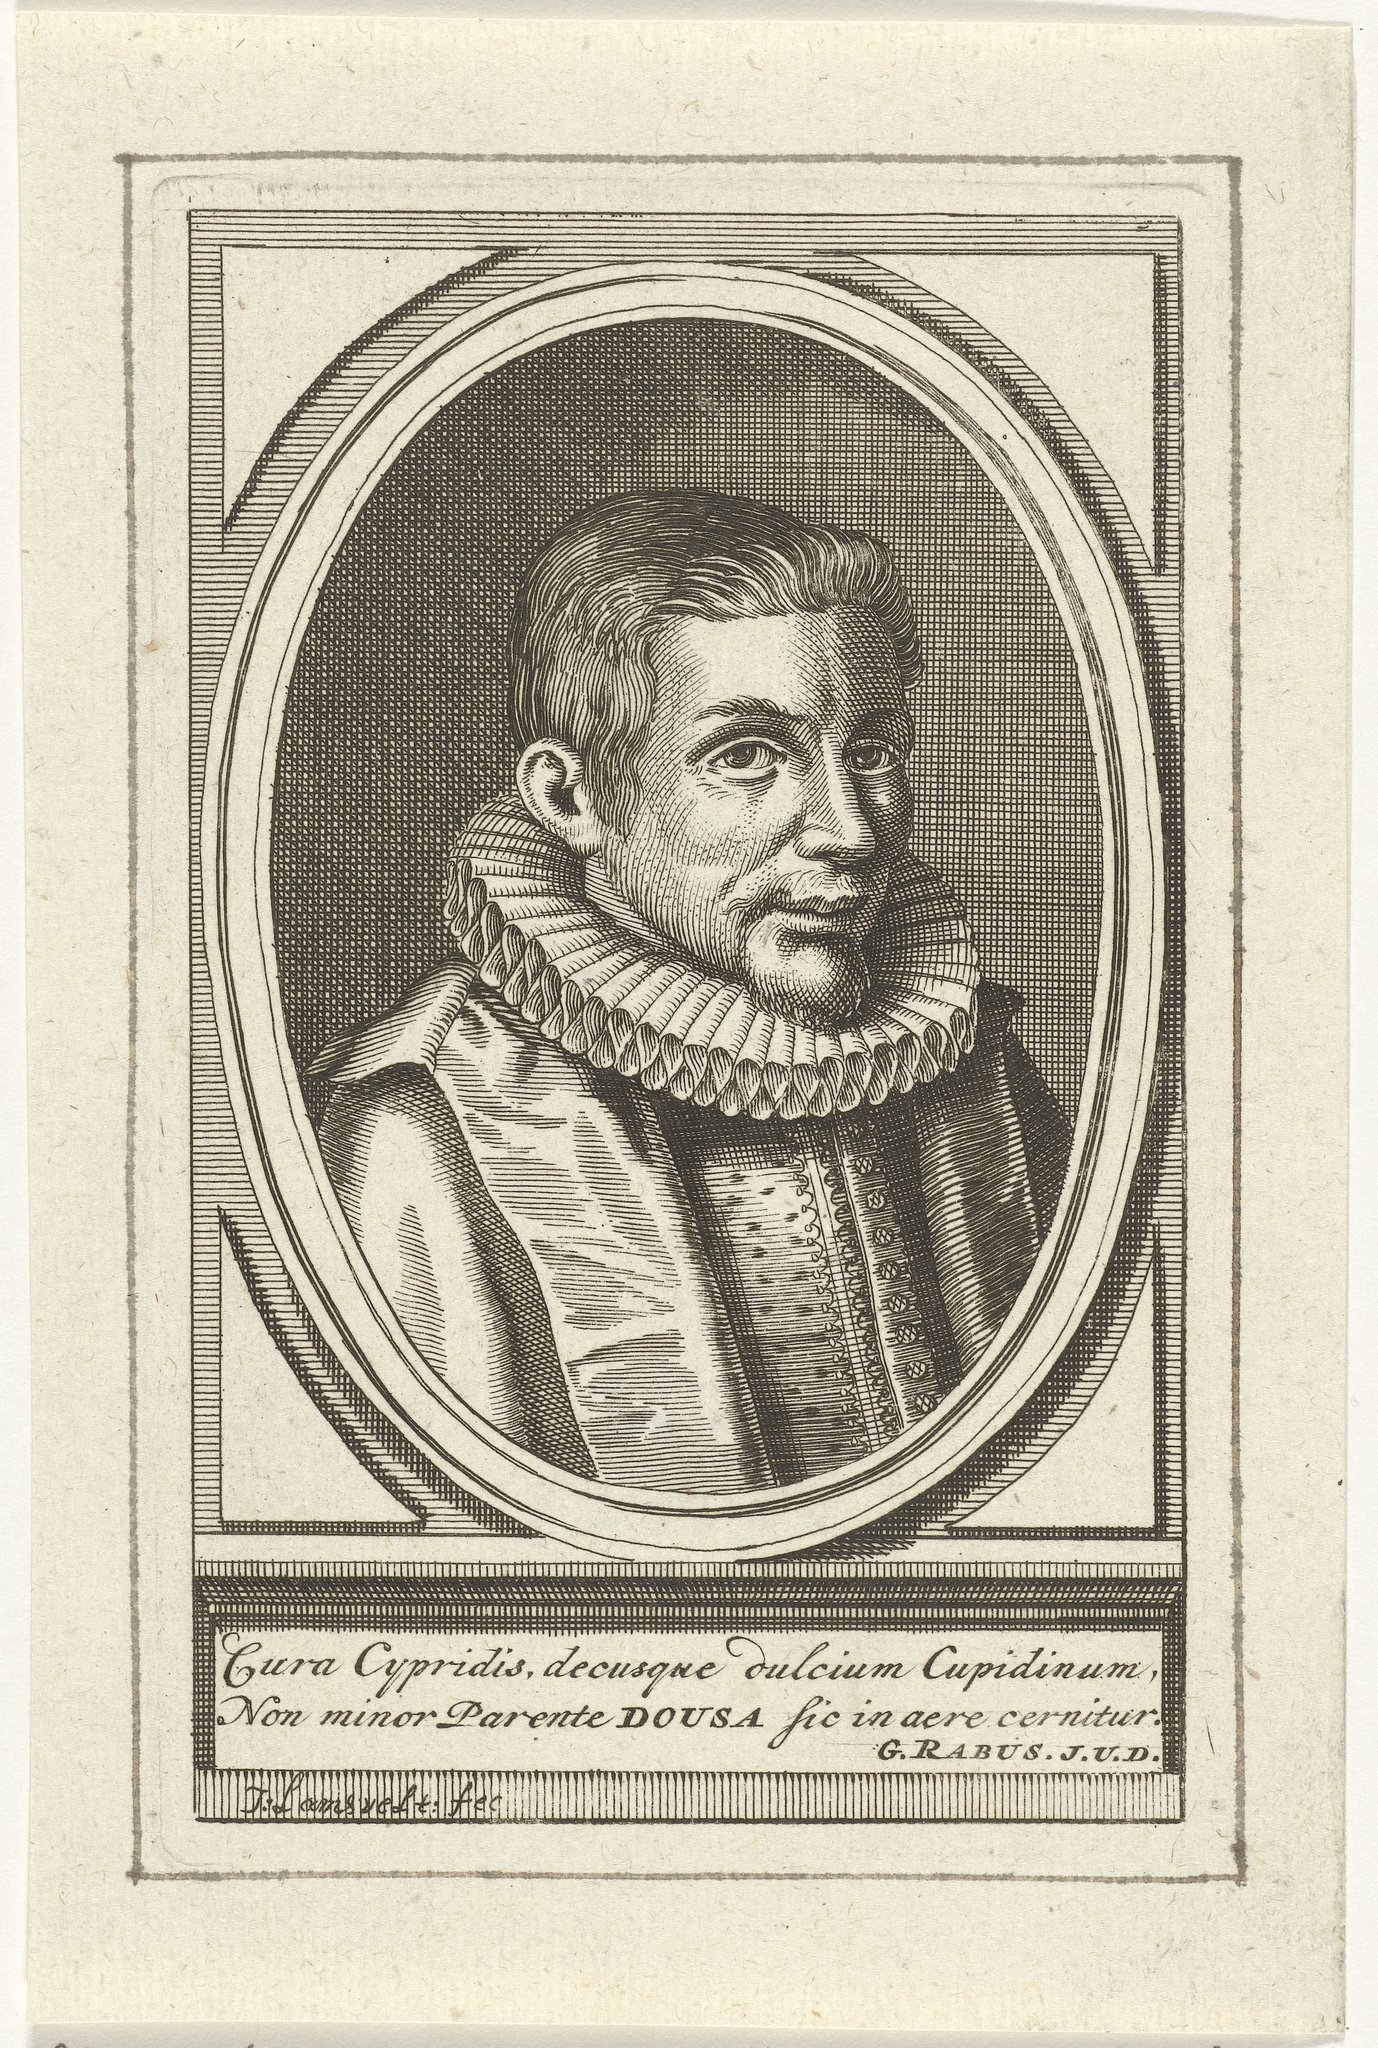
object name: print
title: Portret van Johan van der Does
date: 1684-1743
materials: paper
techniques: engraving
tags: bevelhebber, bibliothecaris, bestuurder, jan van der does (heer van noordwijk en kattendijke)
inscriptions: collector's mark: Lugt 2228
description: Portretbuste in ovaal naar rechts van Johan van der Does, heer van Noordwijk, blootshoofds. Onder het portret staat een tweeregelig vers in het Latijn.